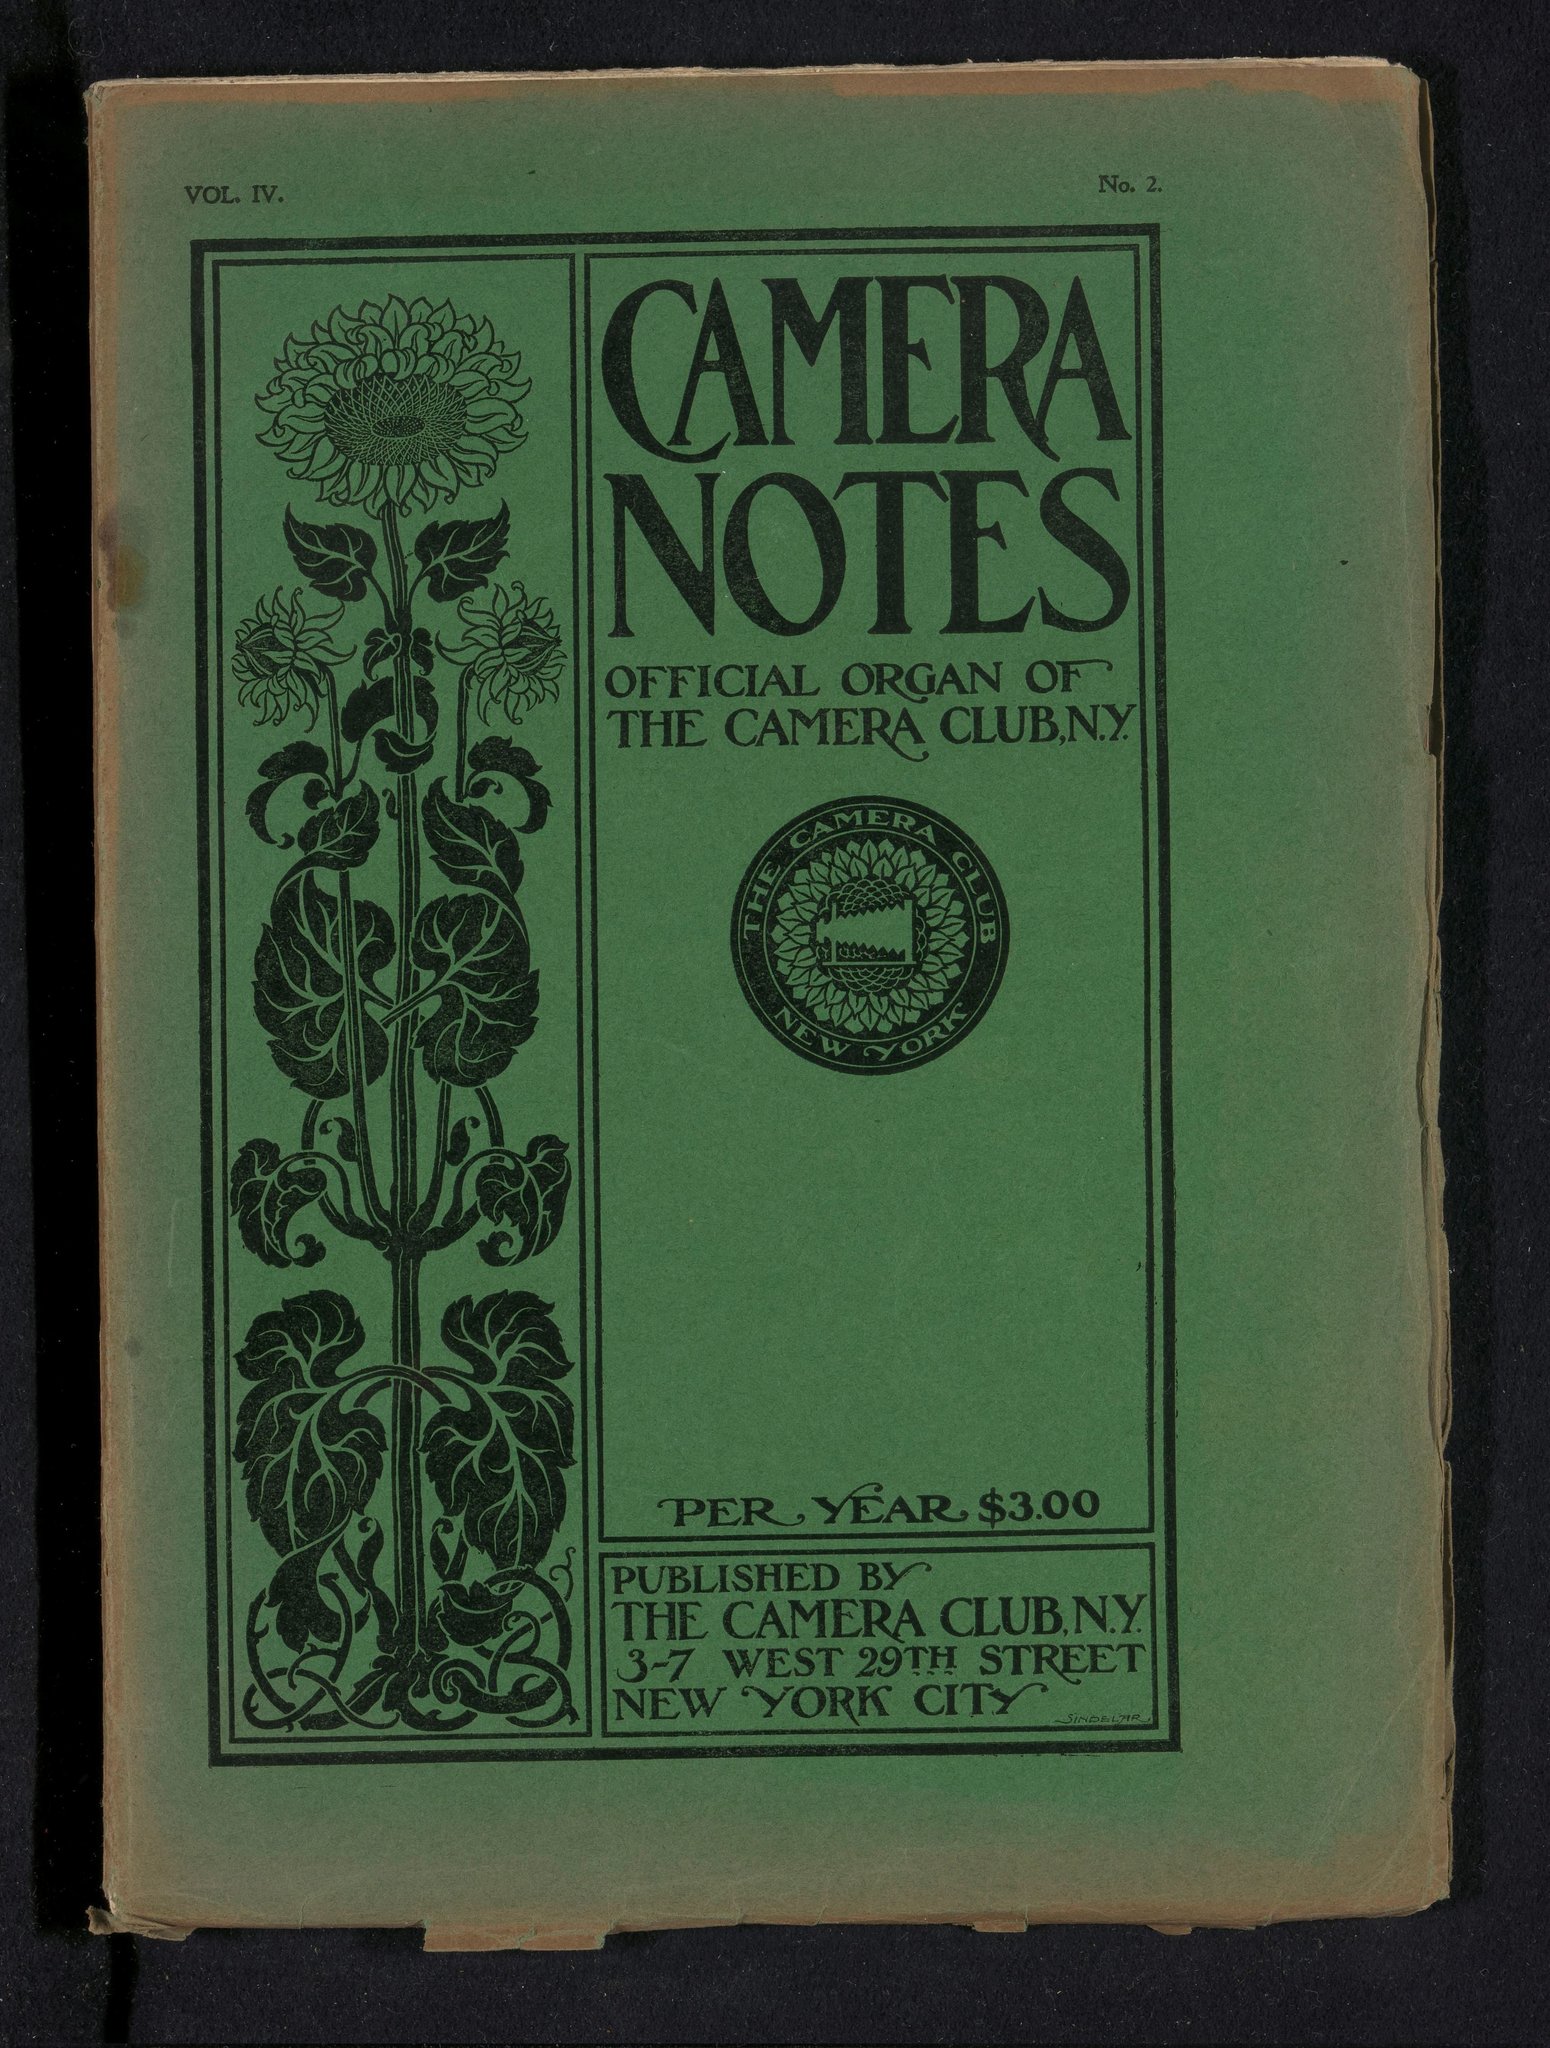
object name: book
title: Camera notes / The Camera Club of New York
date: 1900-1901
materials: cardboard, paper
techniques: photoaquatint, printing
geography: new york city